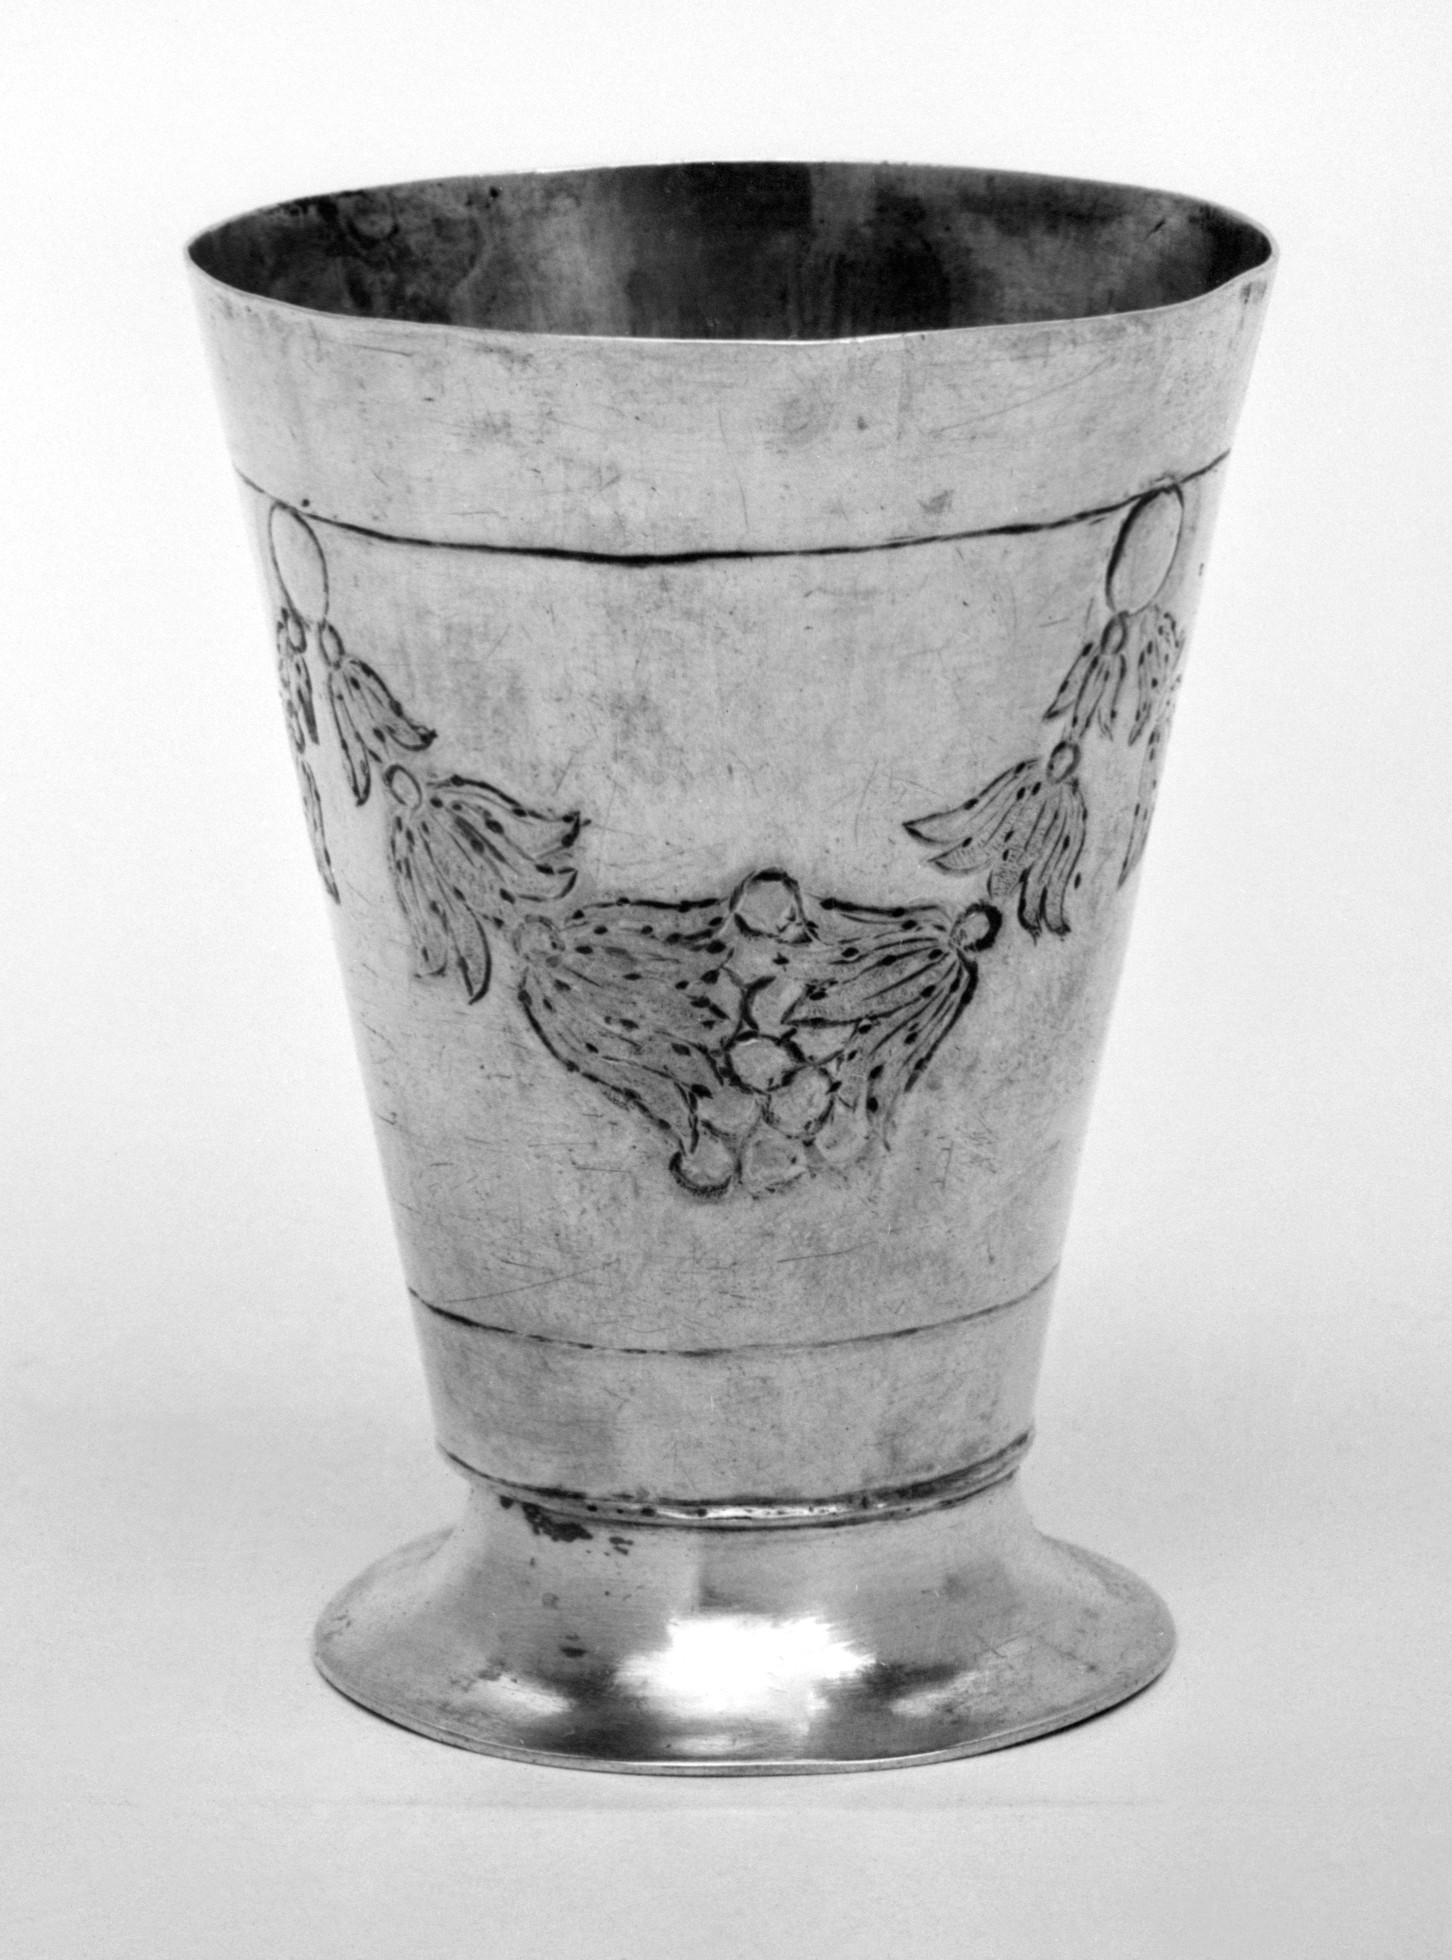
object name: beaker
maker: d.-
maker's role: maker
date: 1701-1800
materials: silver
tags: garlands